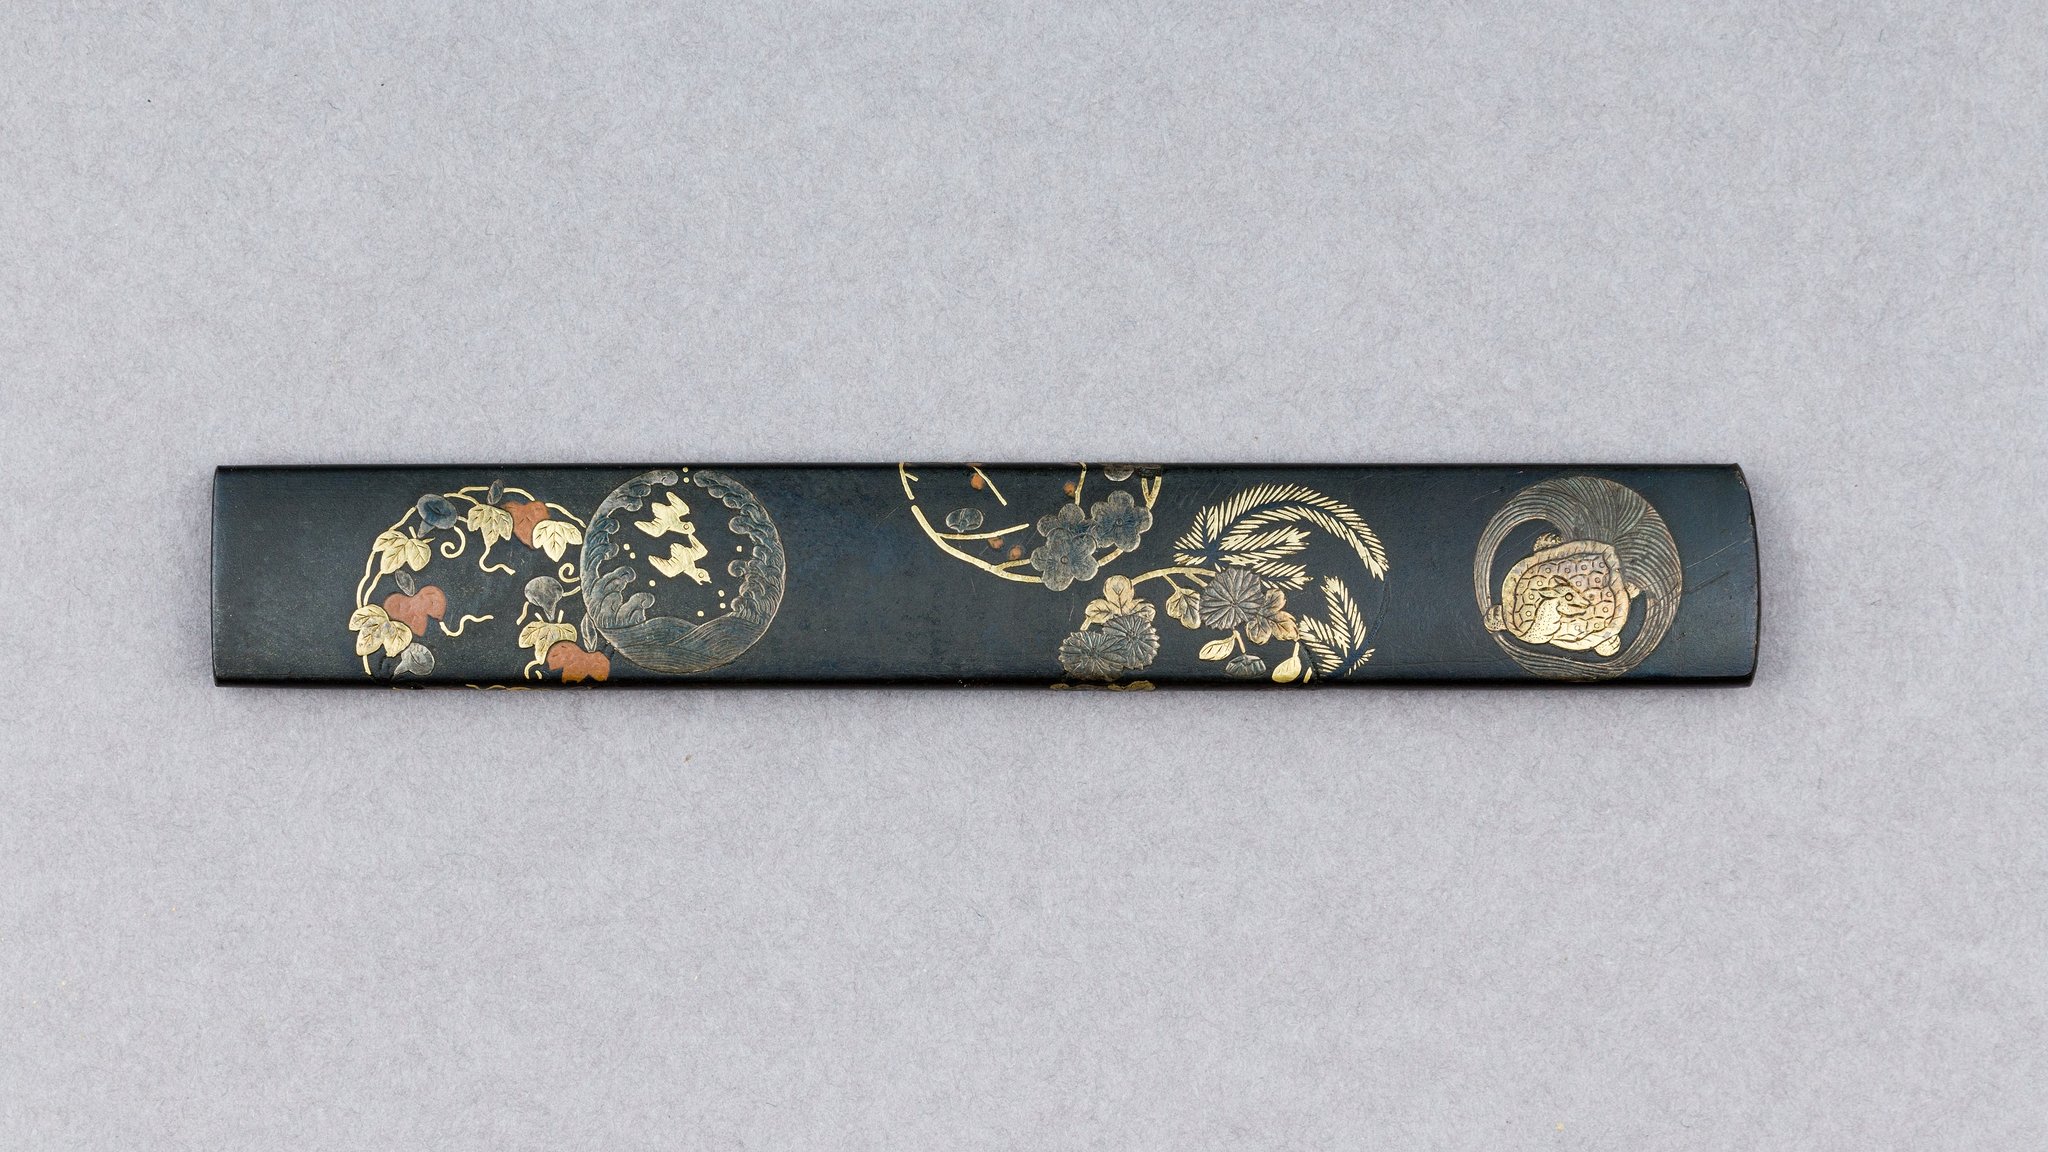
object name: knife handle kozuka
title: Knife Handle (Kozuka)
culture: japanese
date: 1615-1868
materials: copper, silver alloy, gold, silver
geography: japan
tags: flowers